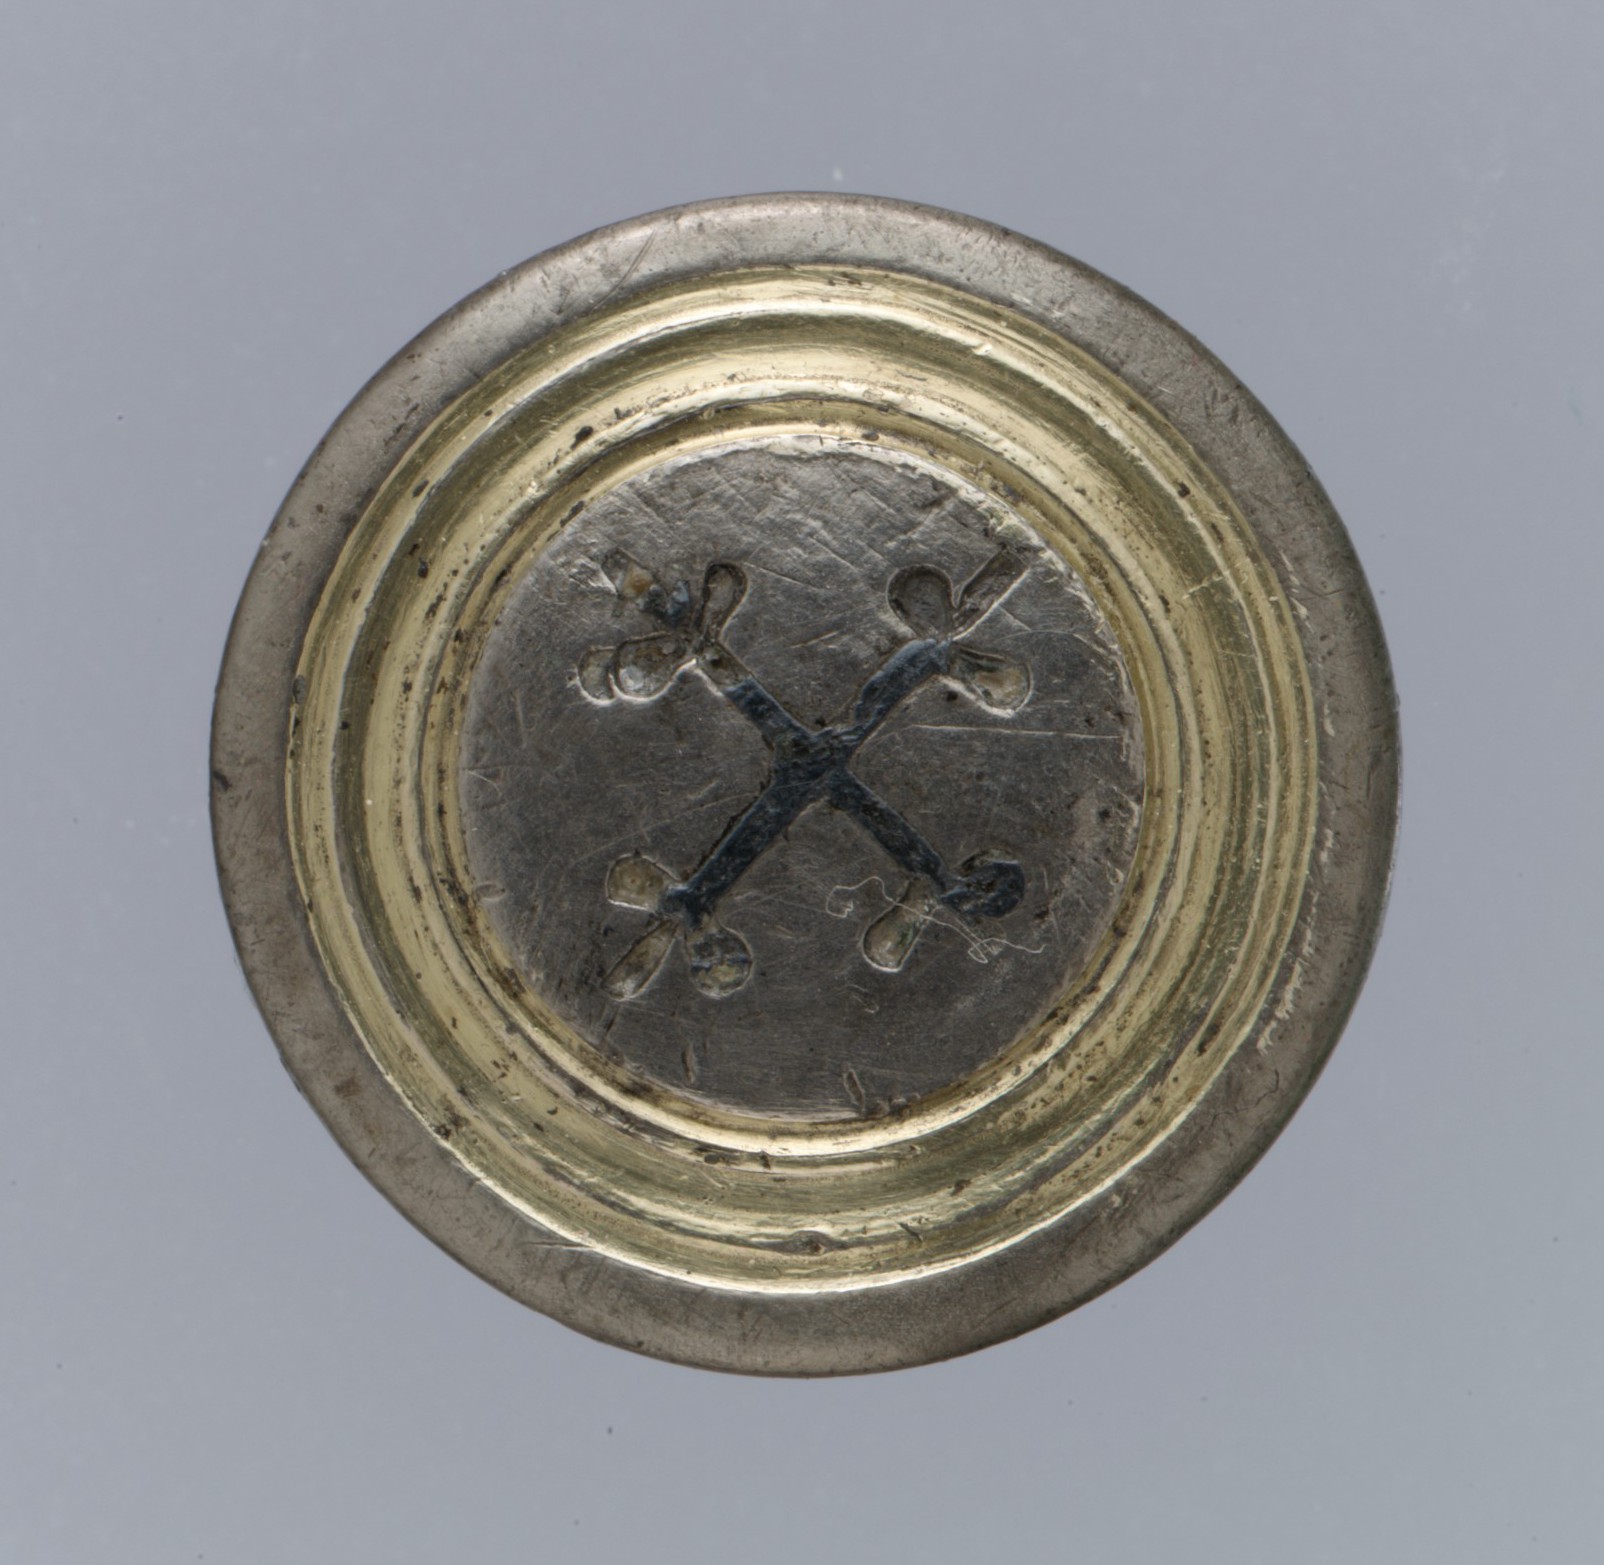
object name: brooch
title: Disk brooch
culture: roman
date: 367-433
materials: niello, silver gilt